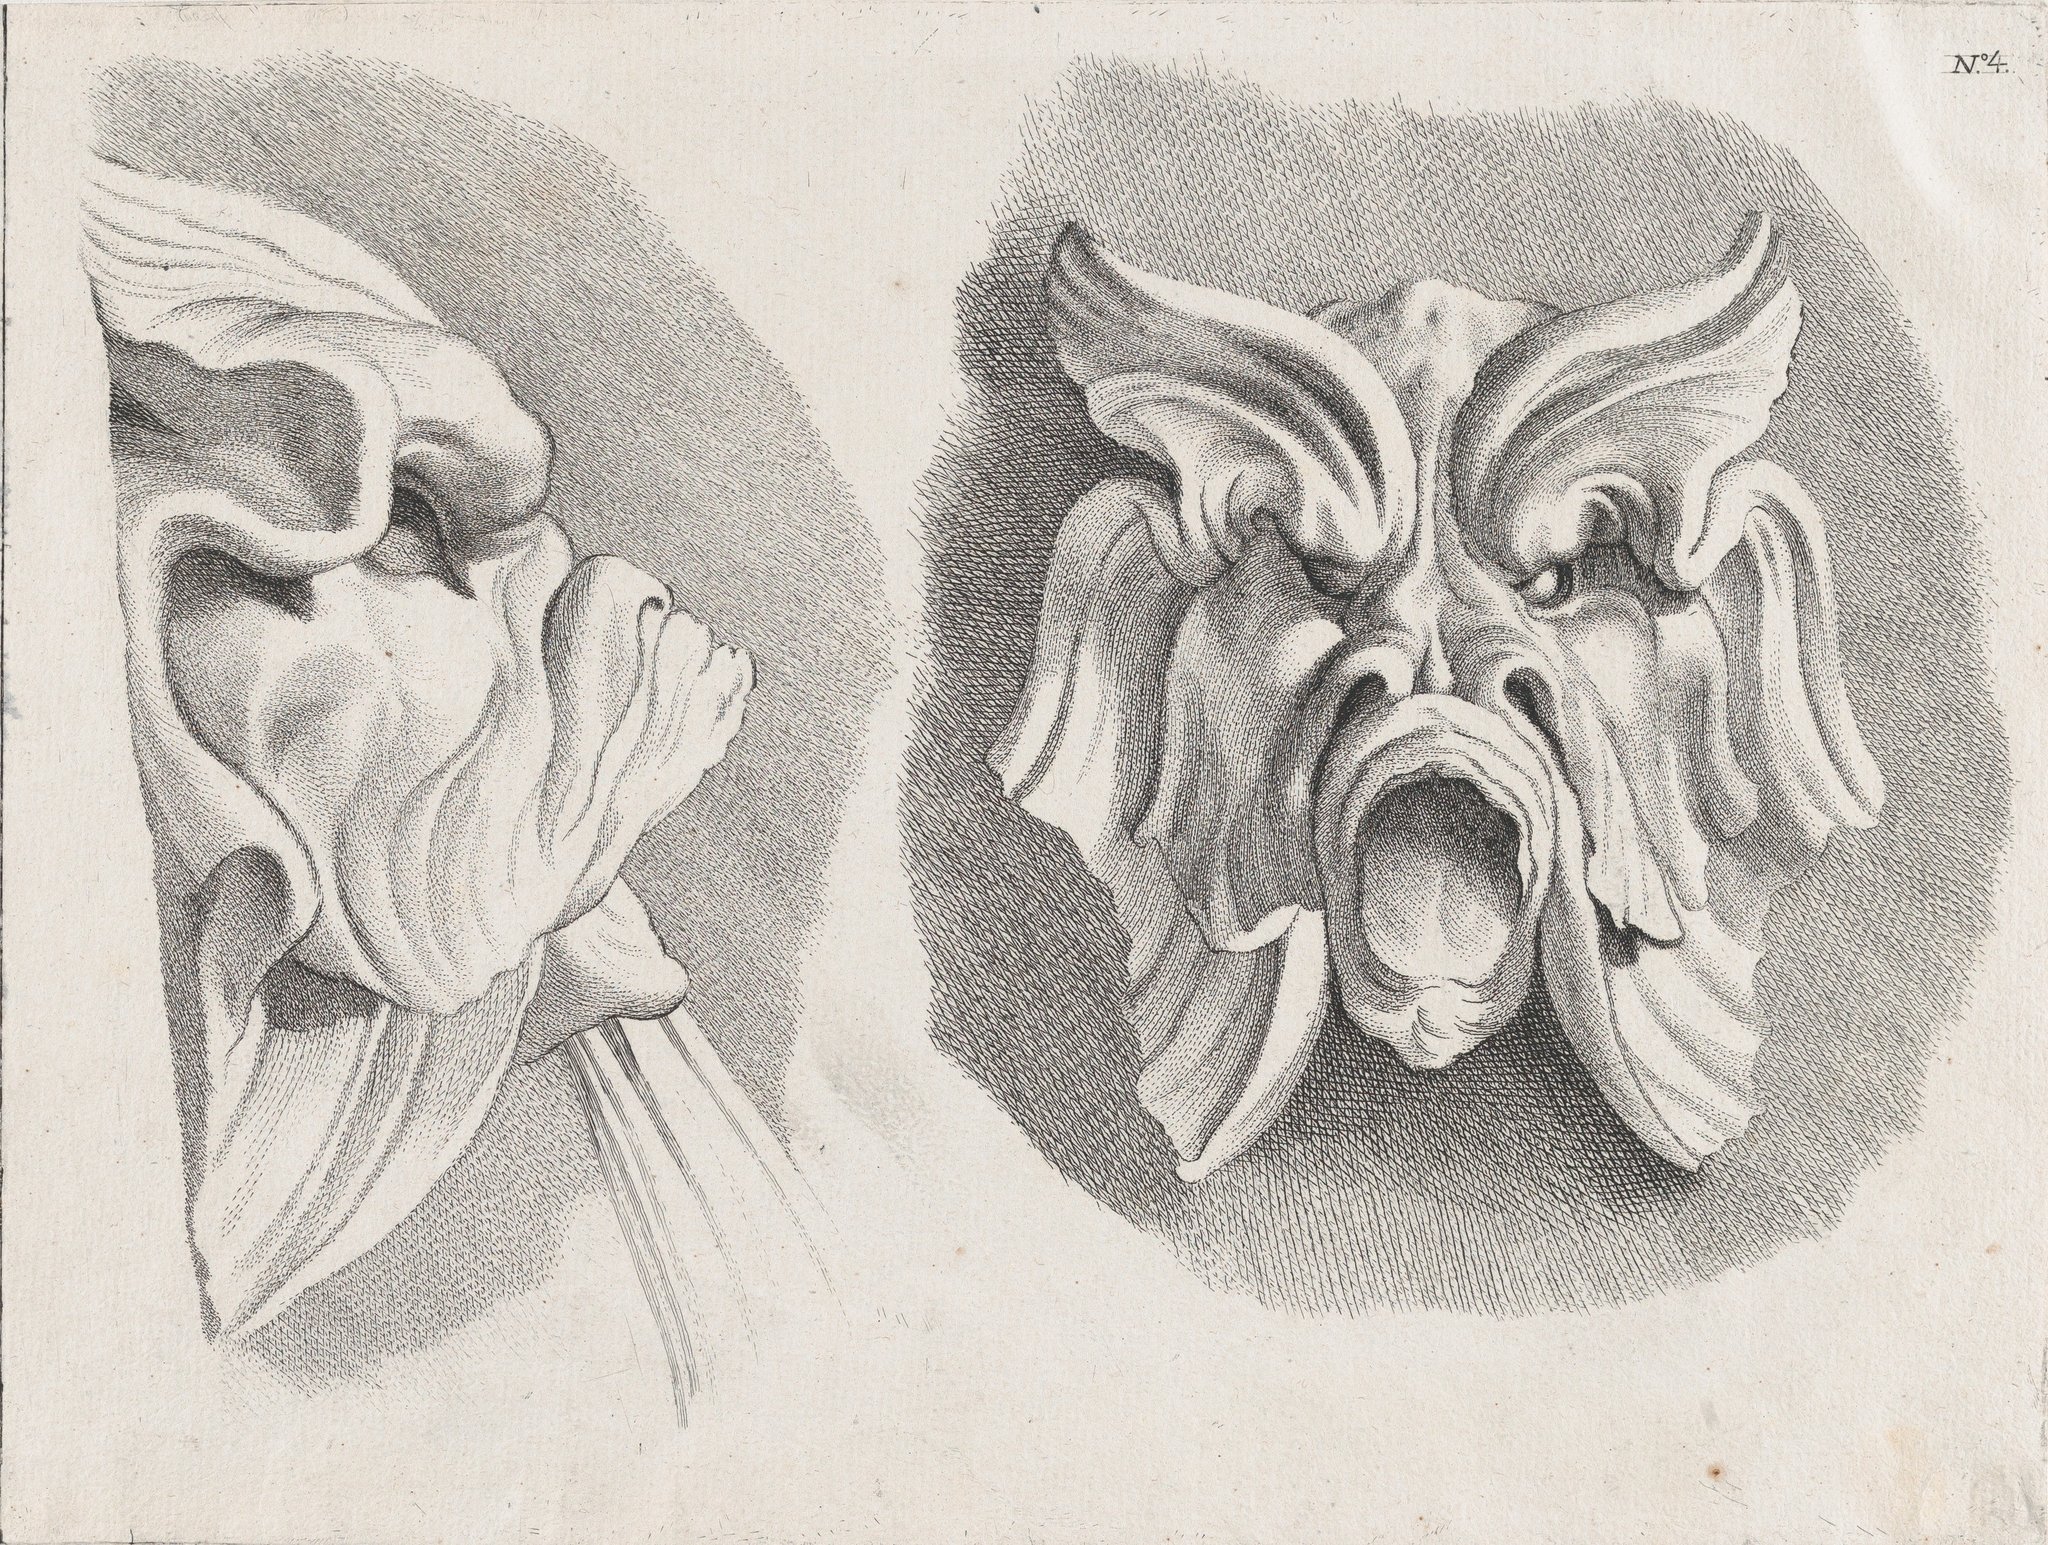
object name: print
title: Fountain head, after the Fontaine des Quatre-Saisons (Paris)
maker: anonymous, french, 18th century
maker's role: artist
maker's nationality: french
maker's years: 1700-1800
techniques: etching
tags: masks